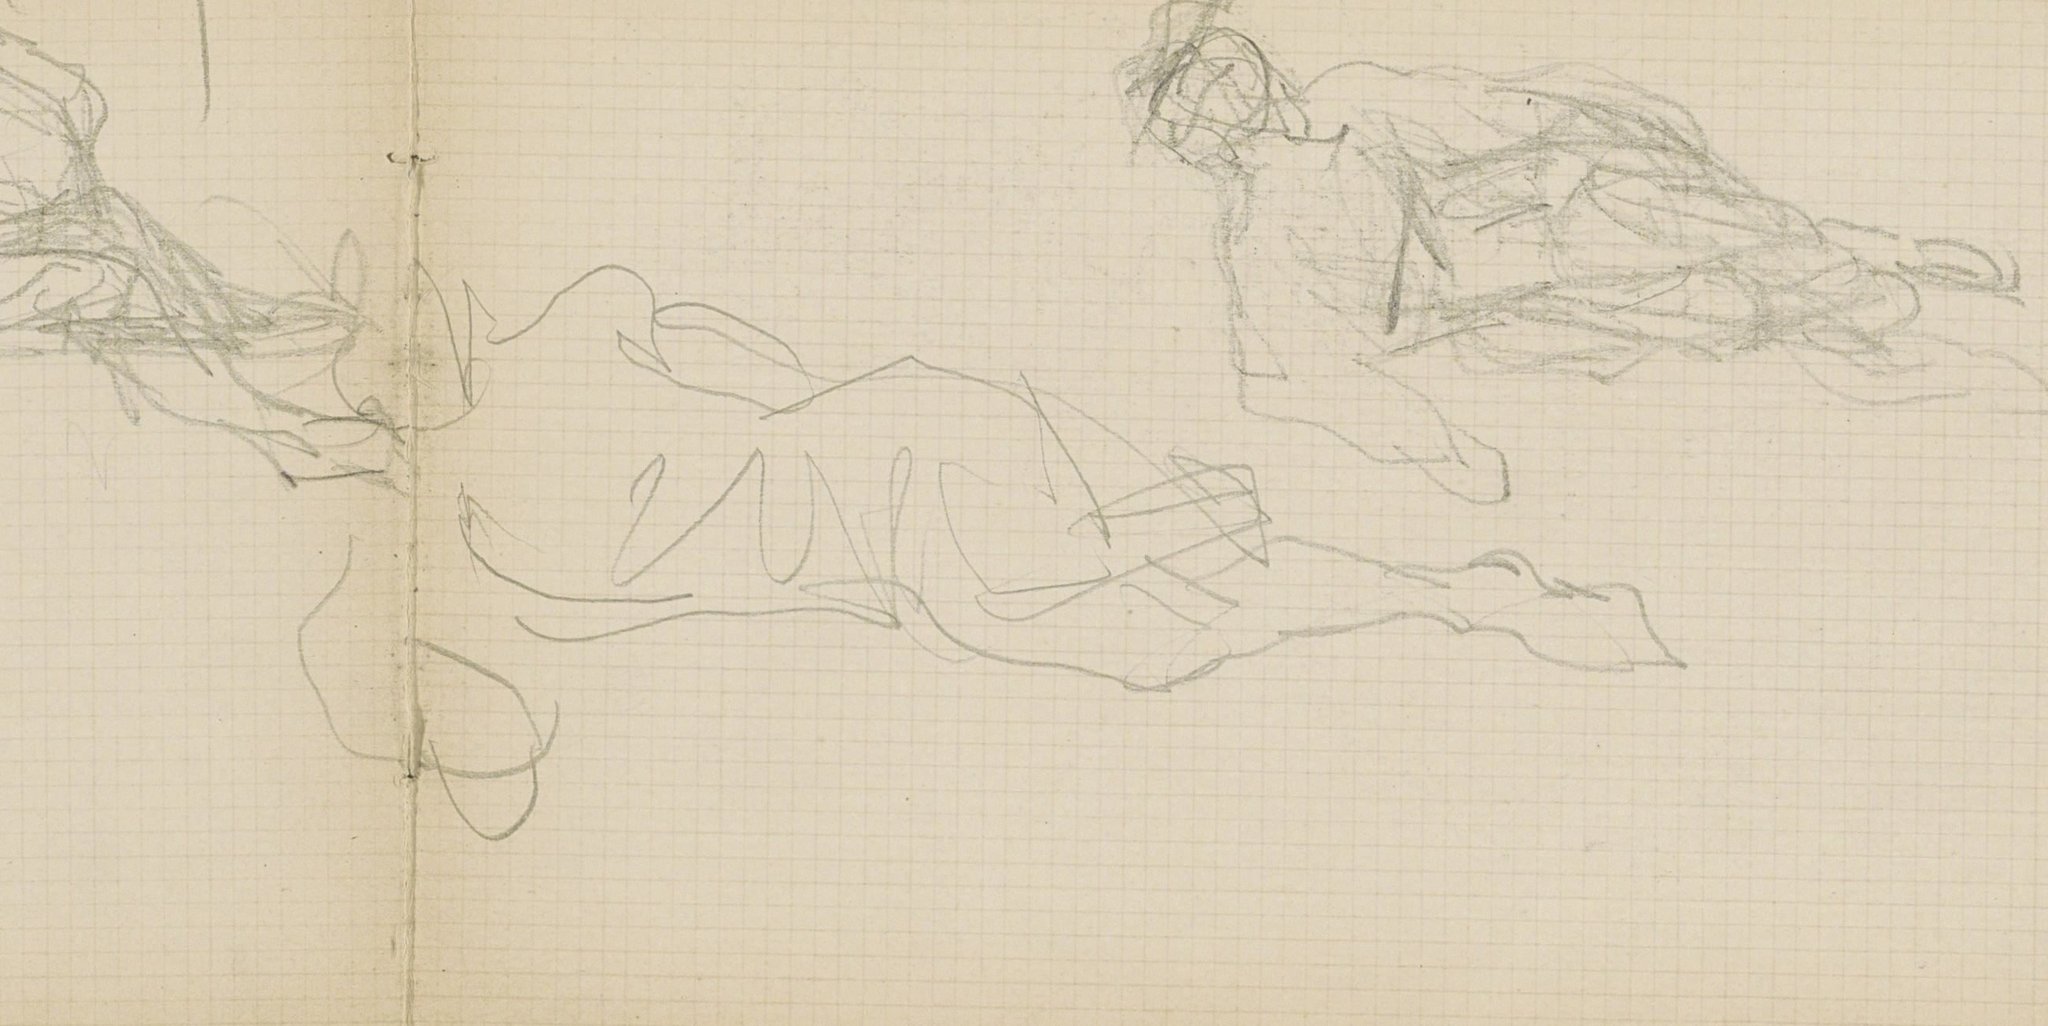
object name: sketchbook leaf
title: Twee liggende figuren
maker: matthijs maris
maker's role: draughtsman, painter, print maker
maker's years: 1839-1917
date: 1849-1917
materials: pencil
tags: lying figure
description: Blad 31 recto uit een schetsboek met 35 bladen.